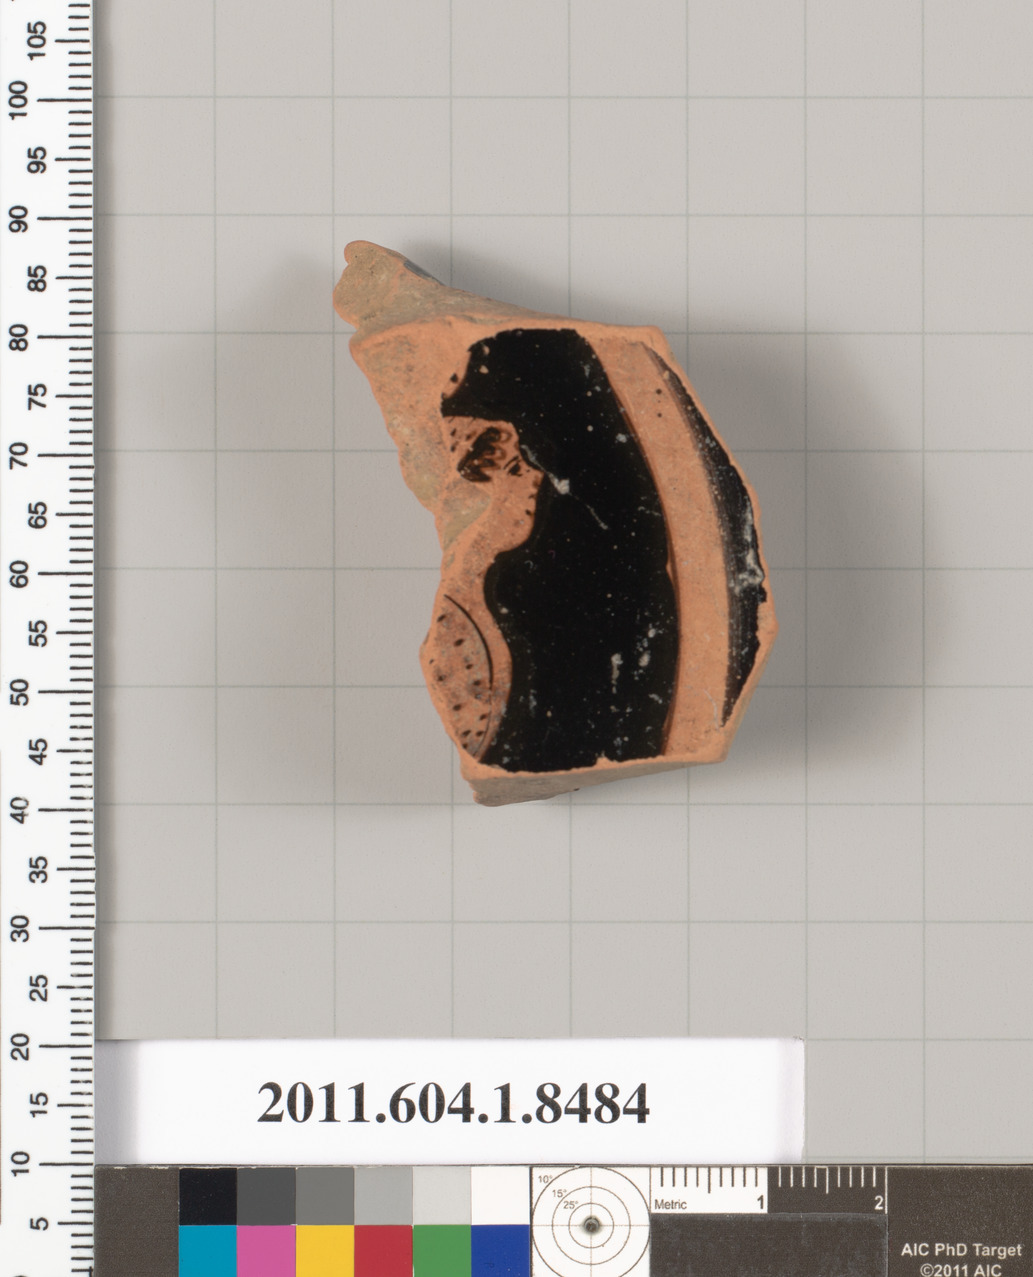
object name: kylix fragment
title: Terracotta fragment of a stemless kylix (drinking cup)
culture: greek, attic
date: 460-450 BCE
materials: terracotta